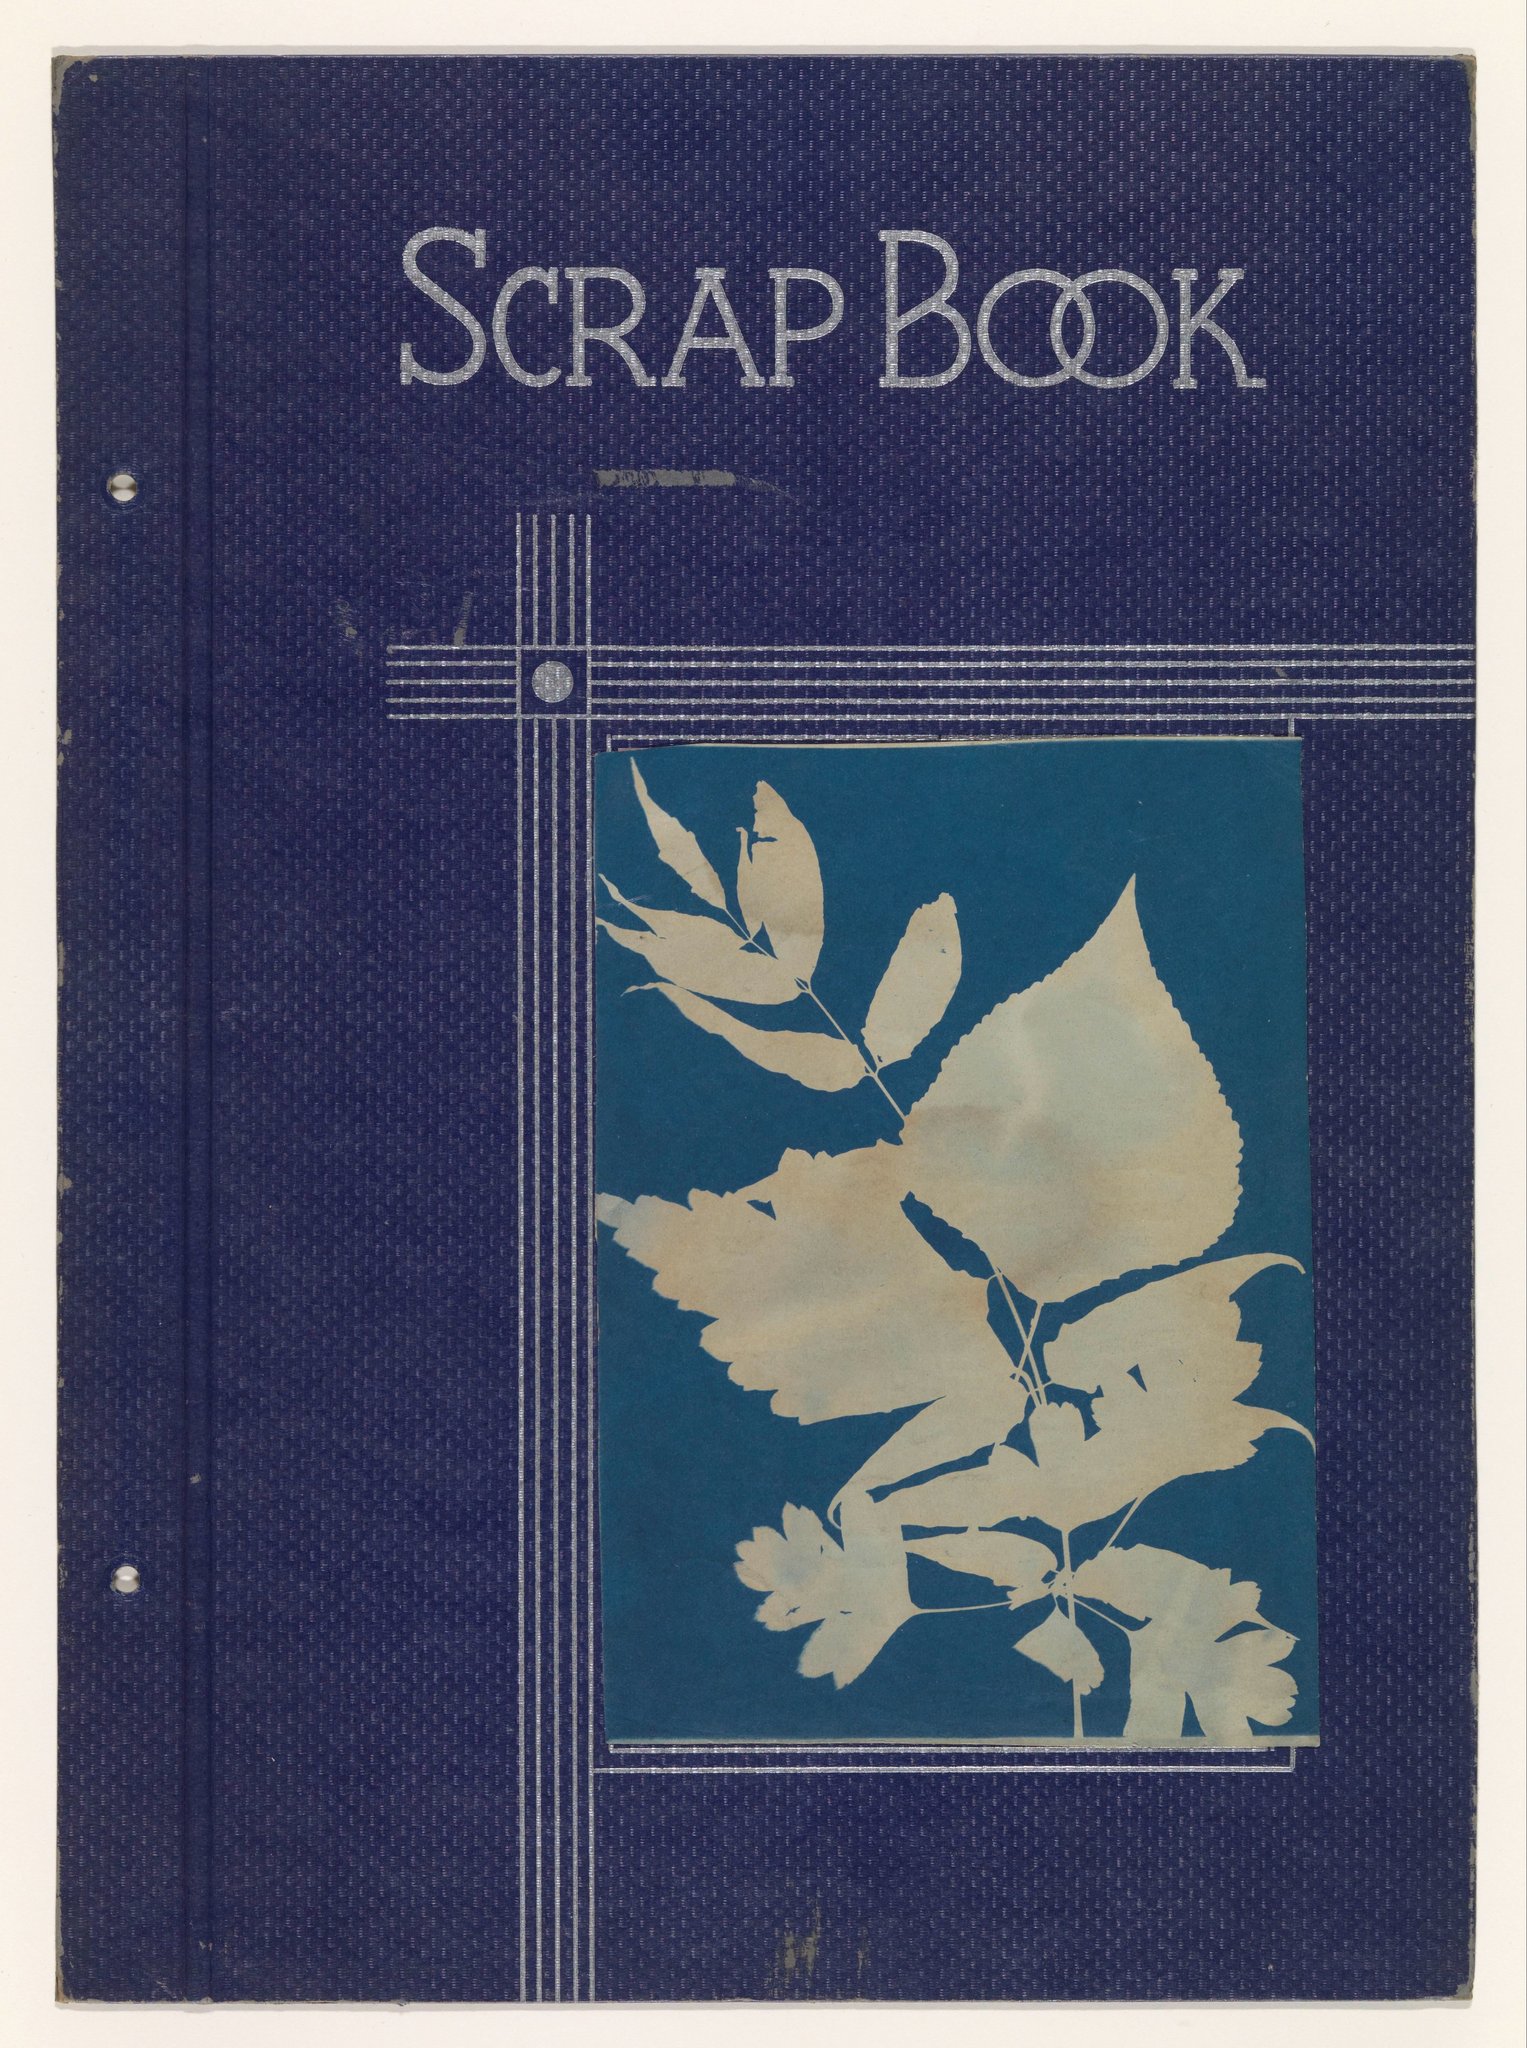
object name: wrapper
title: Blad met cyanotypie fotogram van blad van een Witte albeel en het blad zelf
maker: Anonymous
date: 1900-1920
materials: cardboard, paper, photographic support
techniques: cyanotype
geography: united states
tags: trees (+ leaf)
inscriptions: annotation: ‘Scrap book’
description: Omslag van het album waarin onder meer cyanotypieën met fotogrammen van boombladeren en de boombladeren zelf zaten.